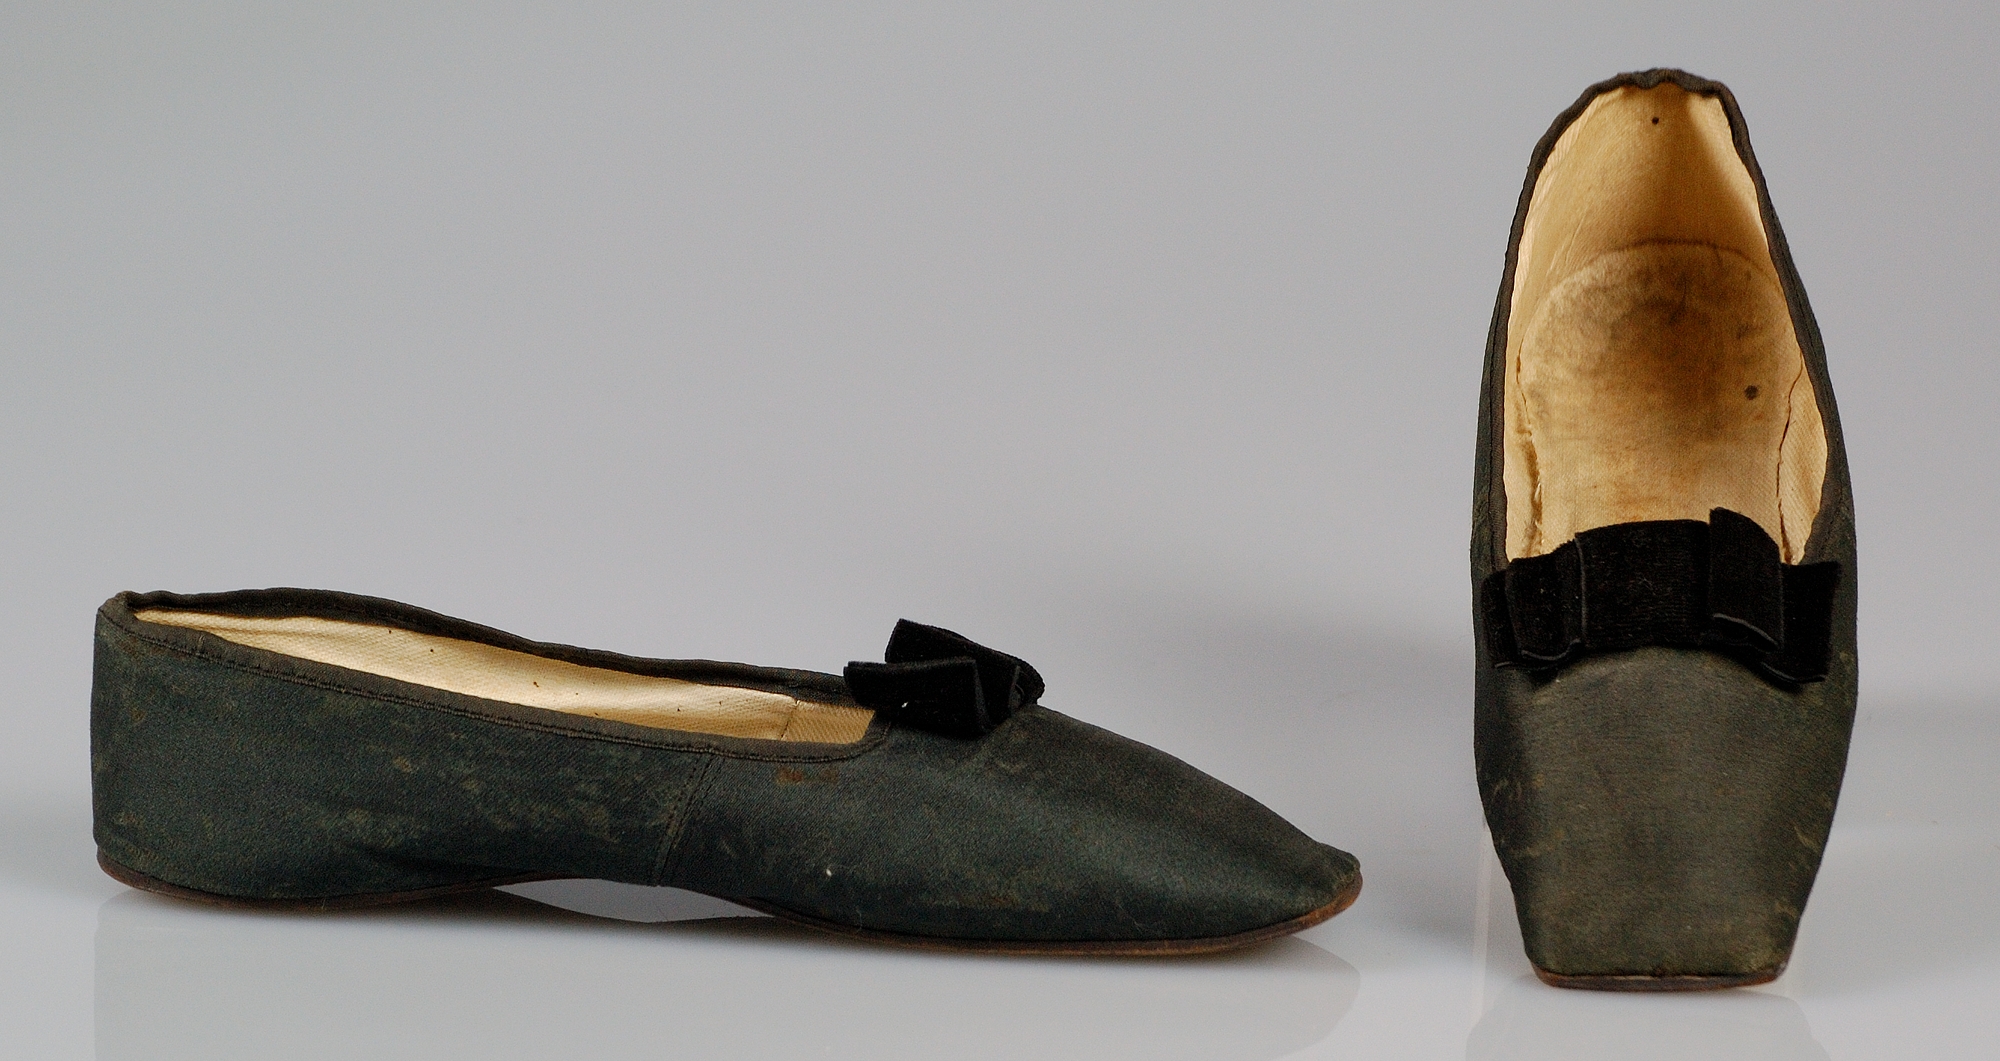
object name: slipper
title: Slippers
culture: american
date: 1835-1850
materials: silk, wool